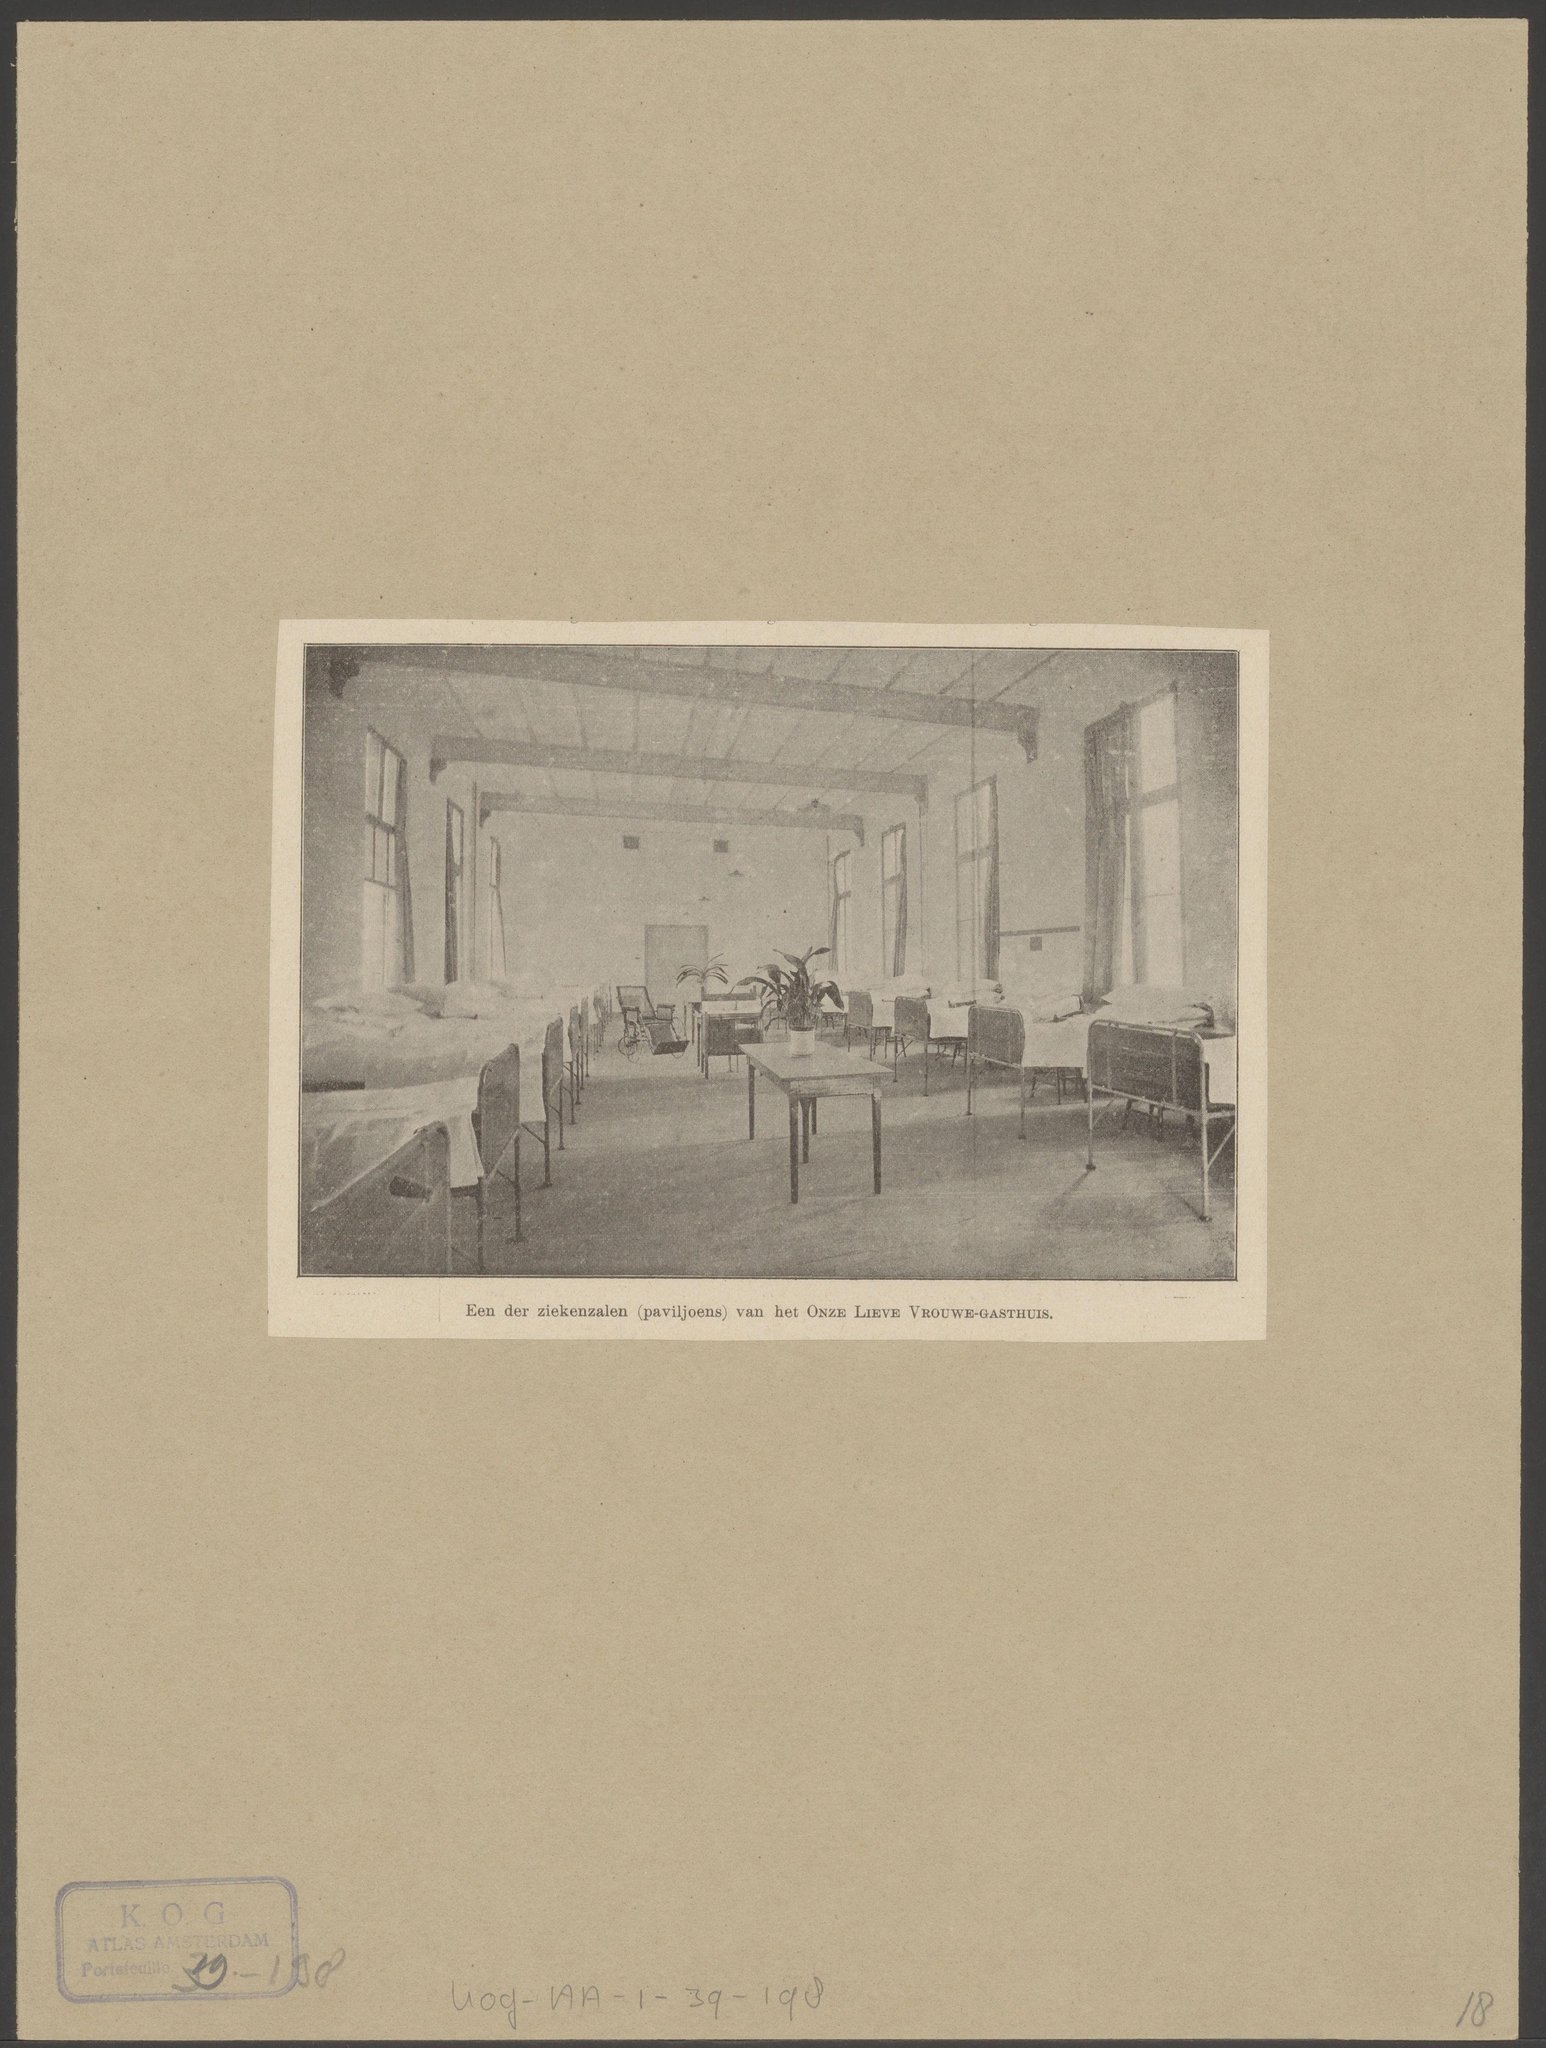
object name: photomechanical print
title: Een der ziekenzalen (paviljoens) van het Onze Lieve Vrouwe-Gasthuis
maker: Anonymous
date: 1898-1915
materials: paper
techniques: letterpress printing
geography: netherlands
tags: hospital, ward; room (in hospital)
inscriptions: collector's mark: Lugt 1641b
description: Onderwerpsrubriek binnen de Atlas Amsterdam: Armwezen en liefdadige instellingen: V. Ziekenhuizen: O.L. Vrouwe Gasthuis.